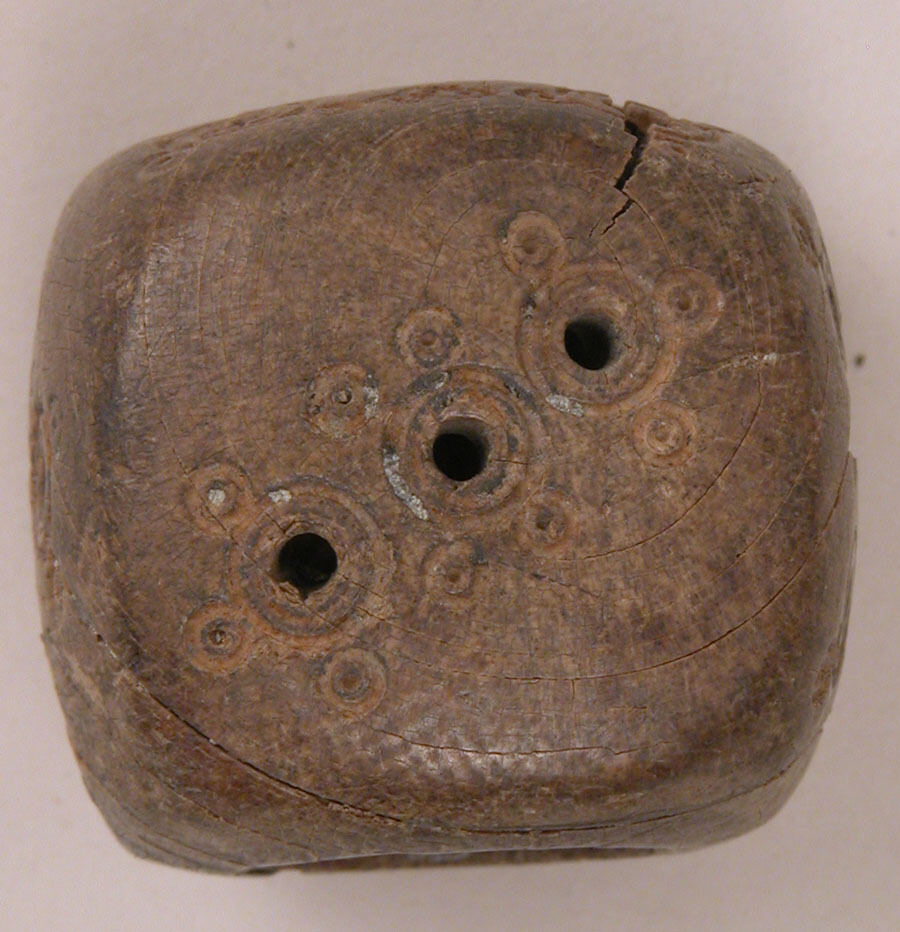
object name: die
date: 1200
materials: ivory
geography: egypt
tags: dice